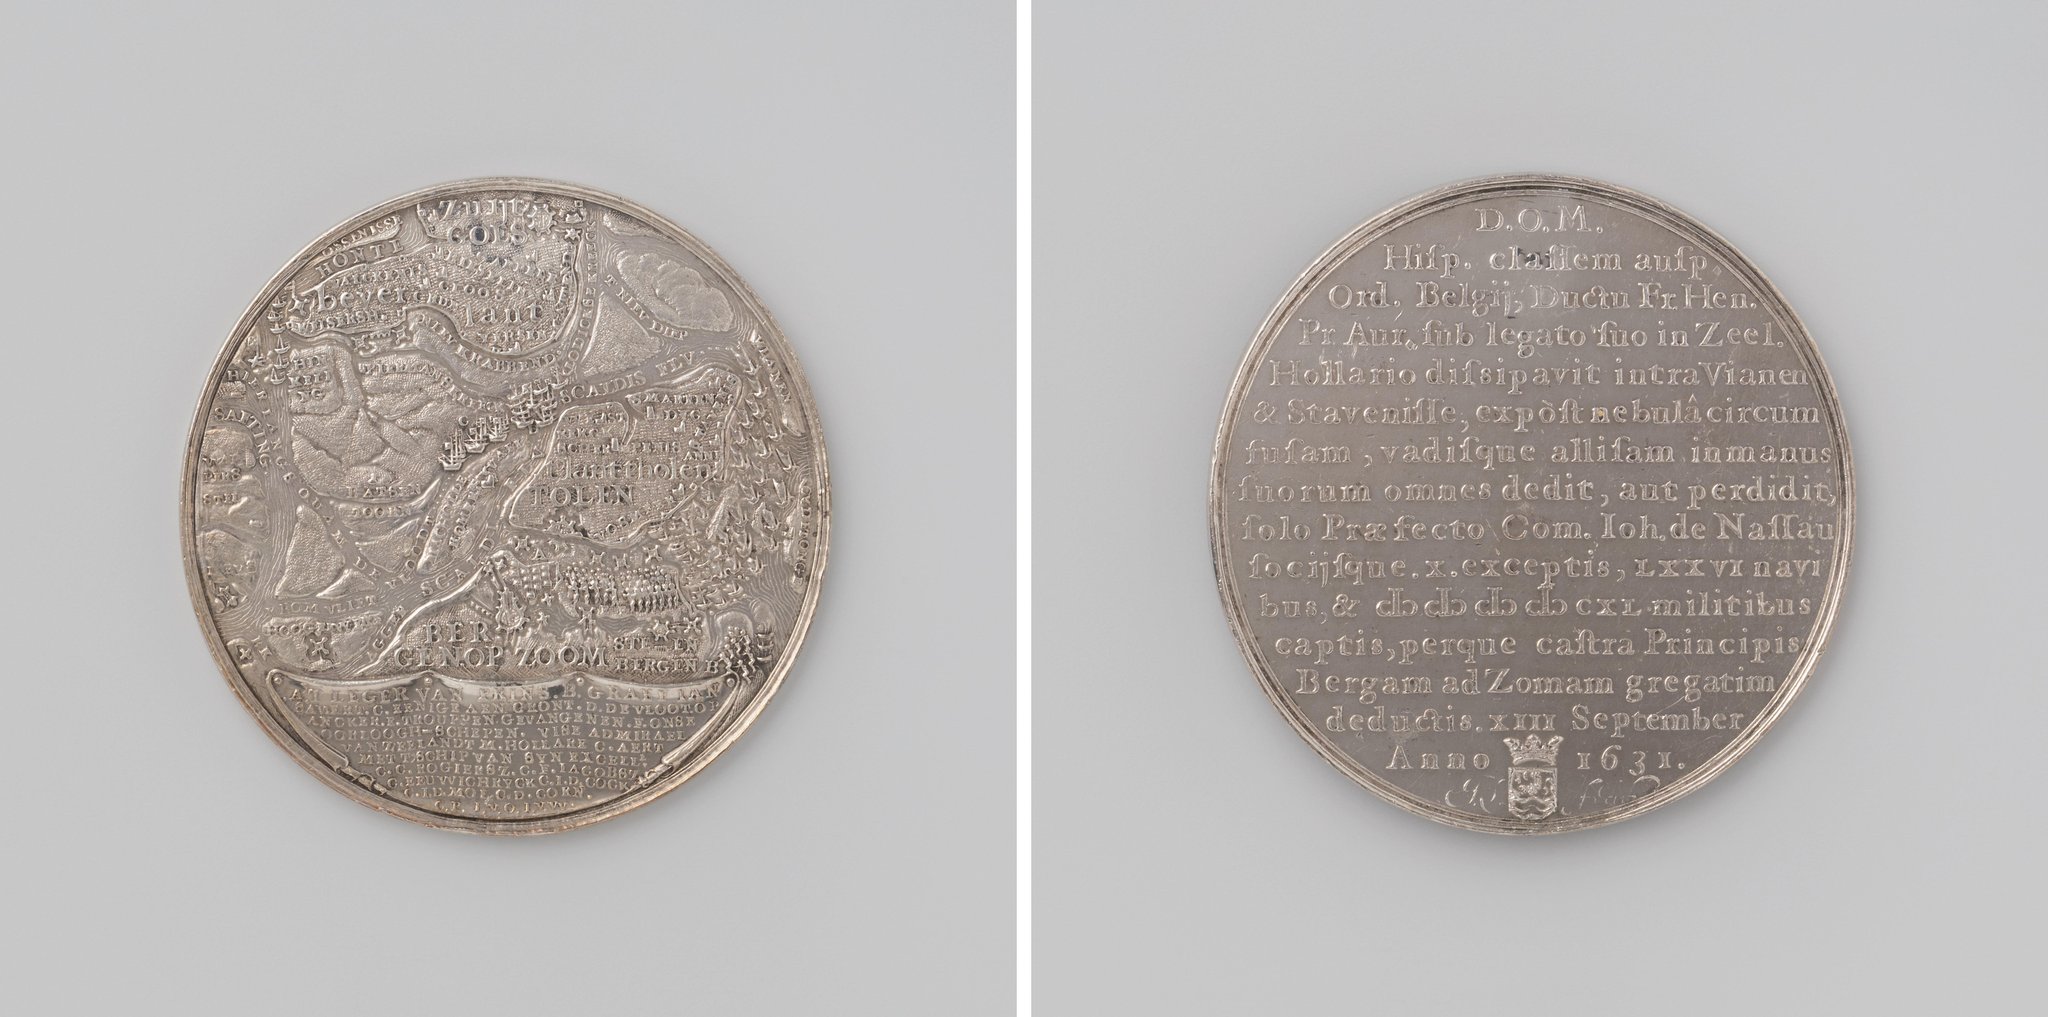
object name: history medal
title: Slag op het Slaak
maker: johannes looff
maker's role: die cutter, draughtsman, print maker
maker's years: -1651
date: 1631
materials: silver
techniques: striking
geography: middelburg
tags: slaak, het, slag op het slaak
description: Zilveren penning. Voorzijde: kaart van Zeeuws stroomgebied met positie van beide vloten boven opschrift. Keerzijde: opschrift boven gekroond wapenschilden